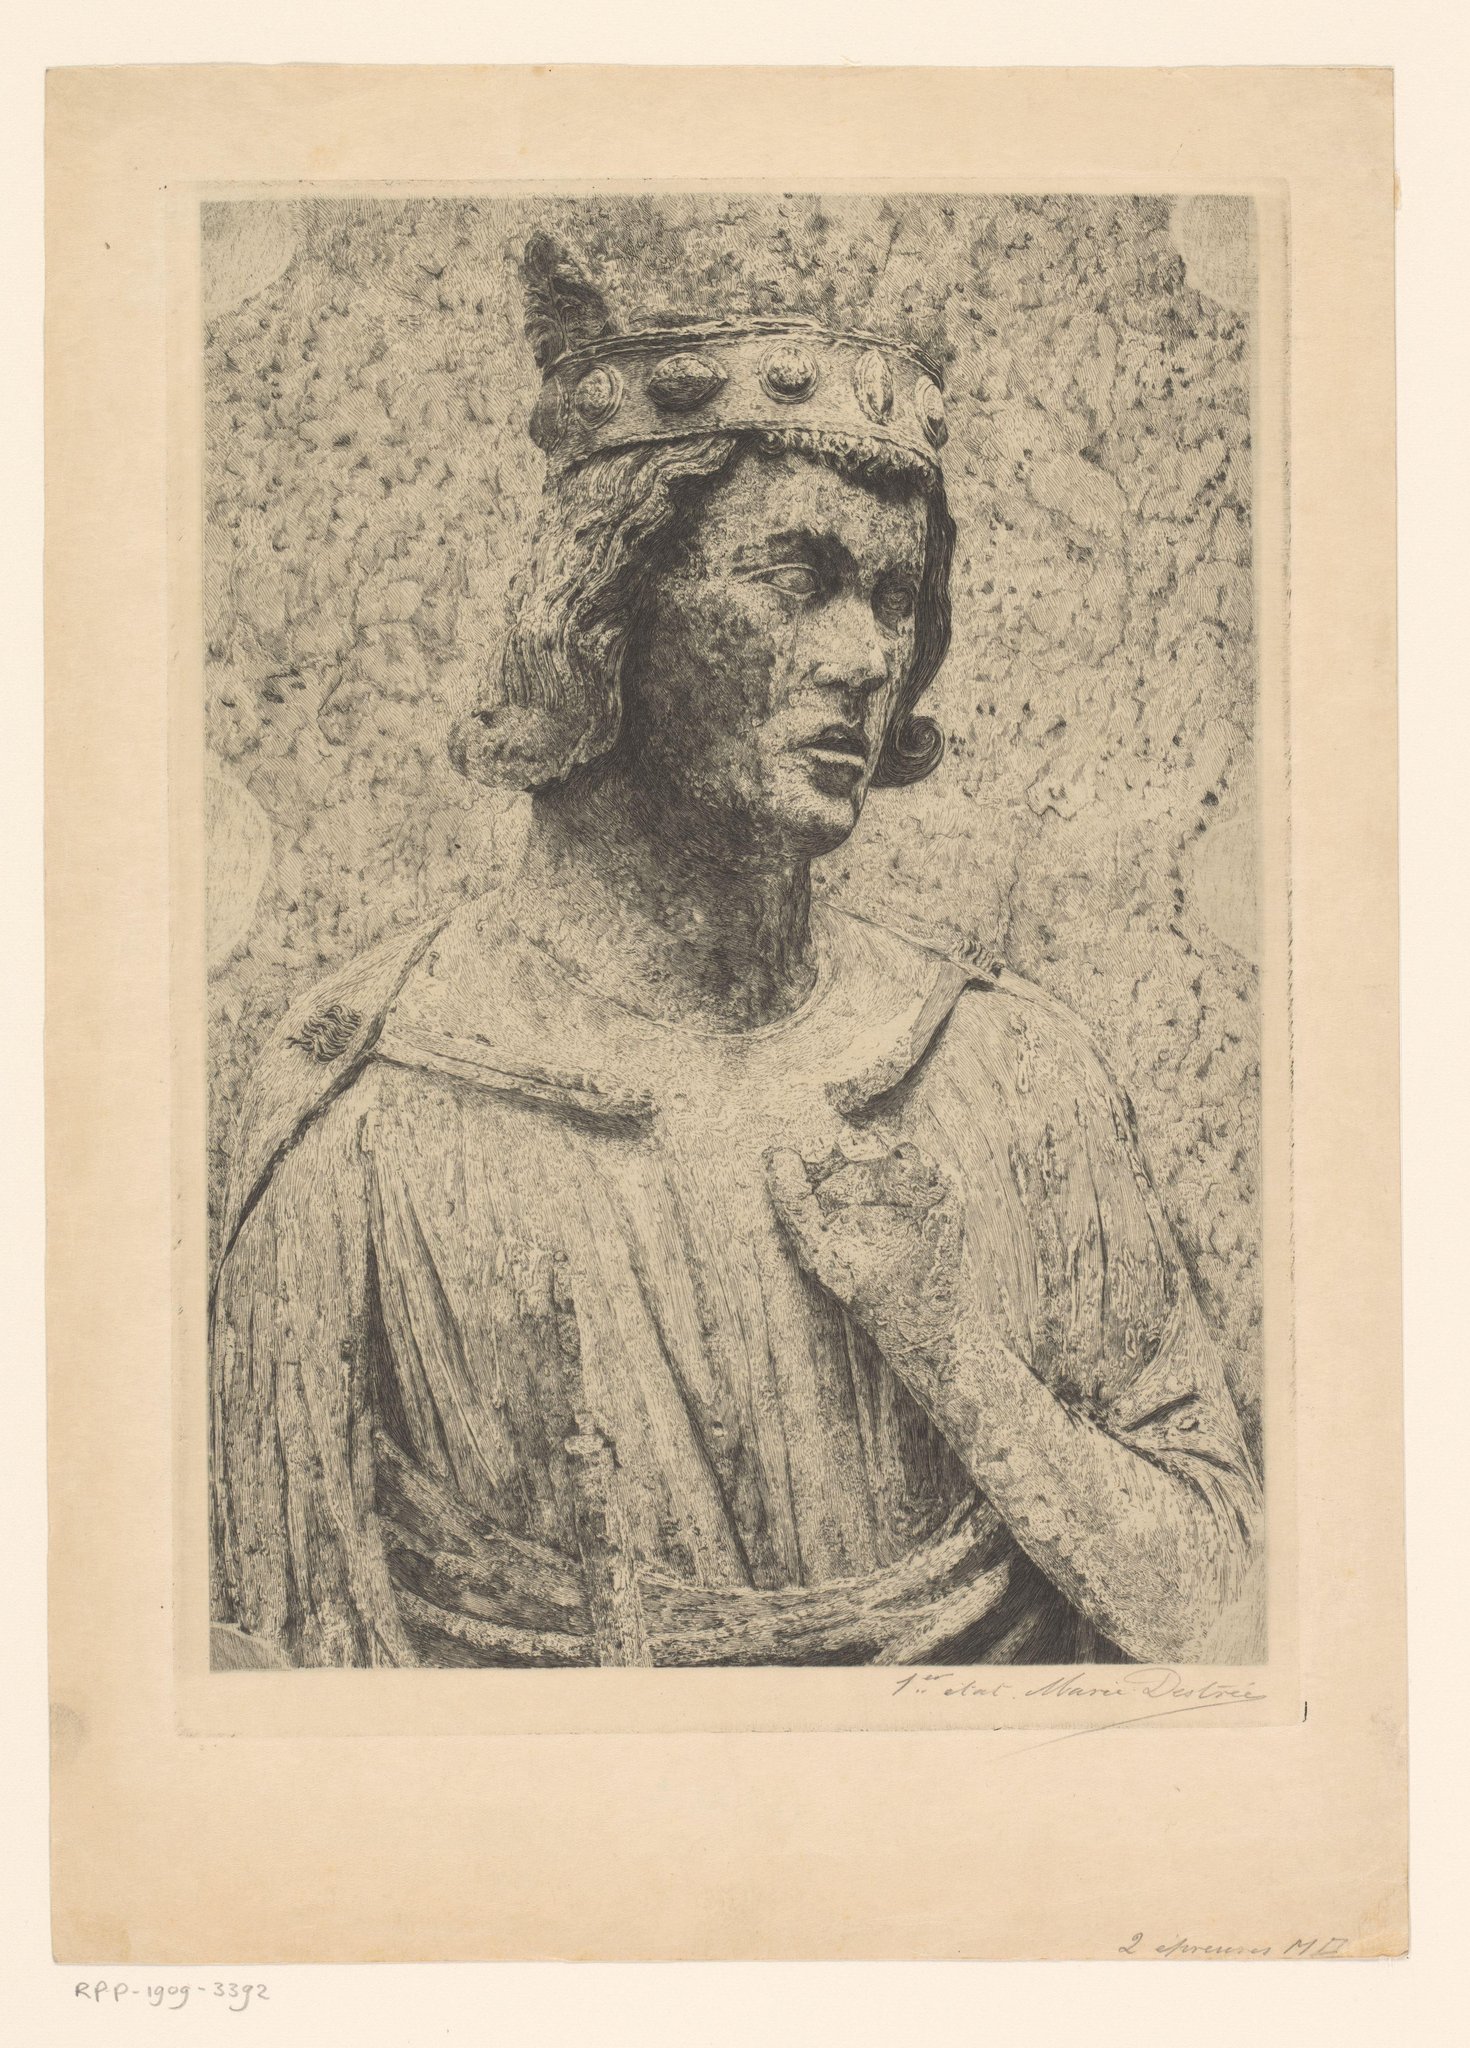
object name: print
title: Beeld van Lodewijk IX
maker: marie danse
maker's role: print maker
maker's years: 1867-1942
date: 1889-1909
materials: paper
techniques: etching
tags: piece of sculpture, reproduction of a piece of sculpture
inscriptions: collector's mark: Lugt 2228, inscription: ‘1m etat; 2 epreuves MD’